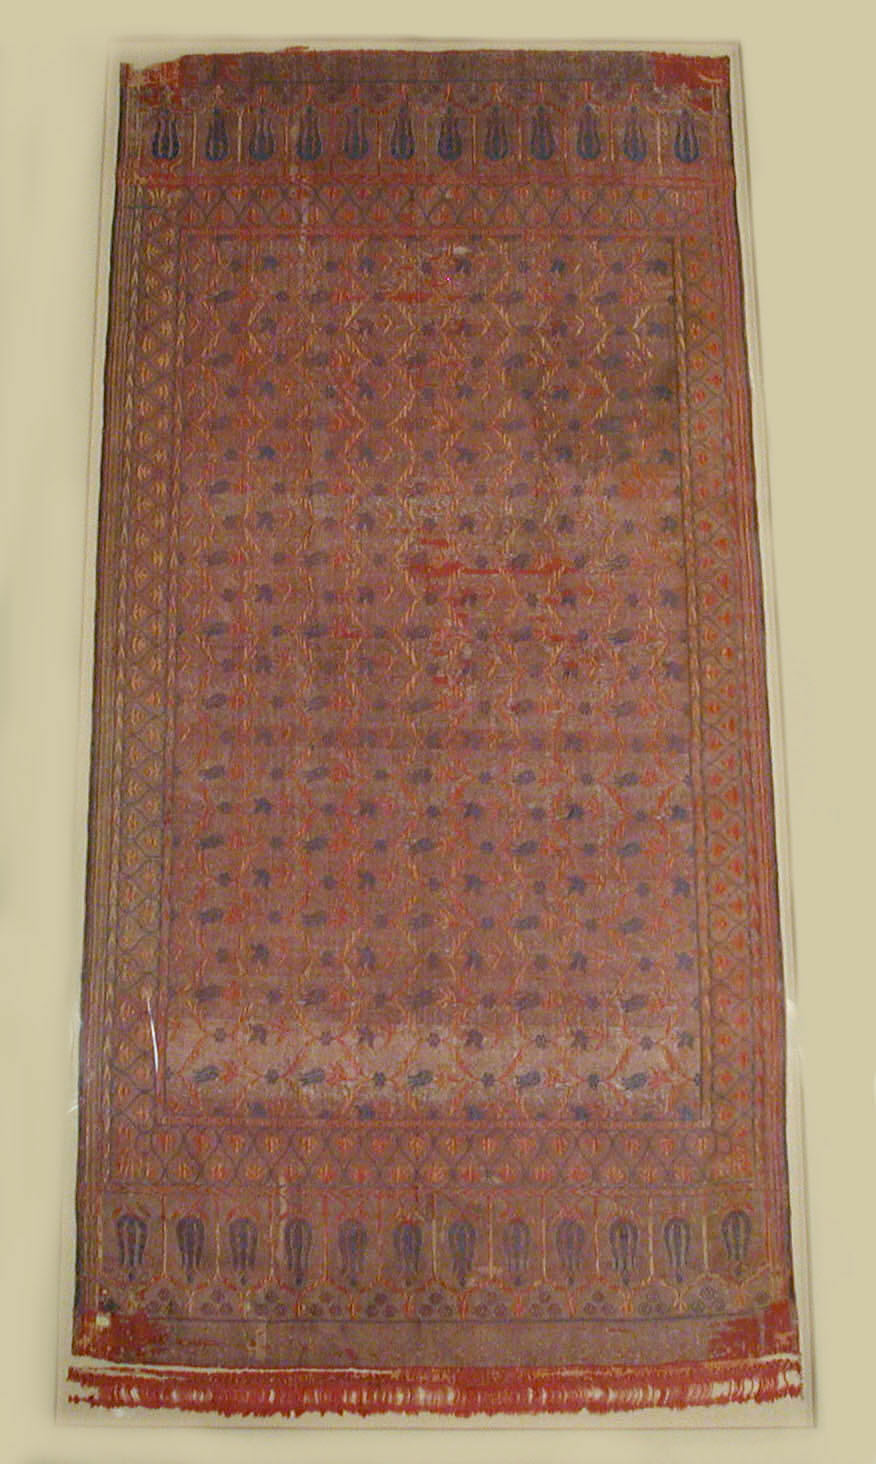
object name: cover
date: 1601-1700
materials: metal thread, silk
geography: turkey